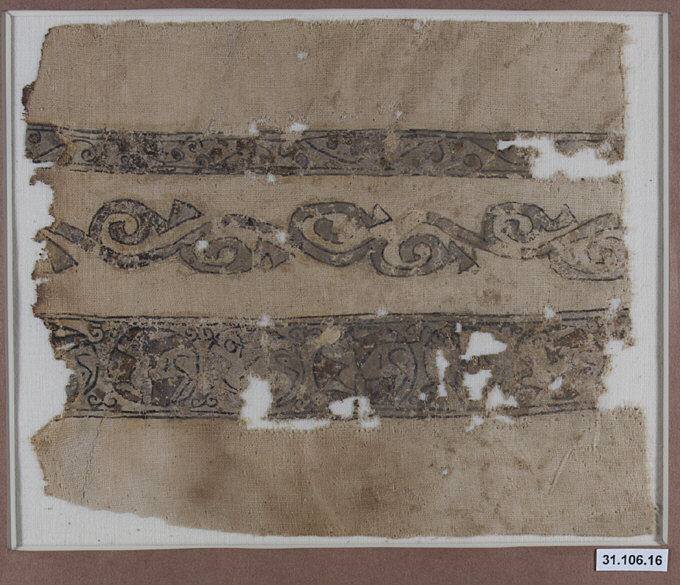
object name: textile fragment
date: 1001-1100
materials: linen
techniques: painting, printing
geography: egypt